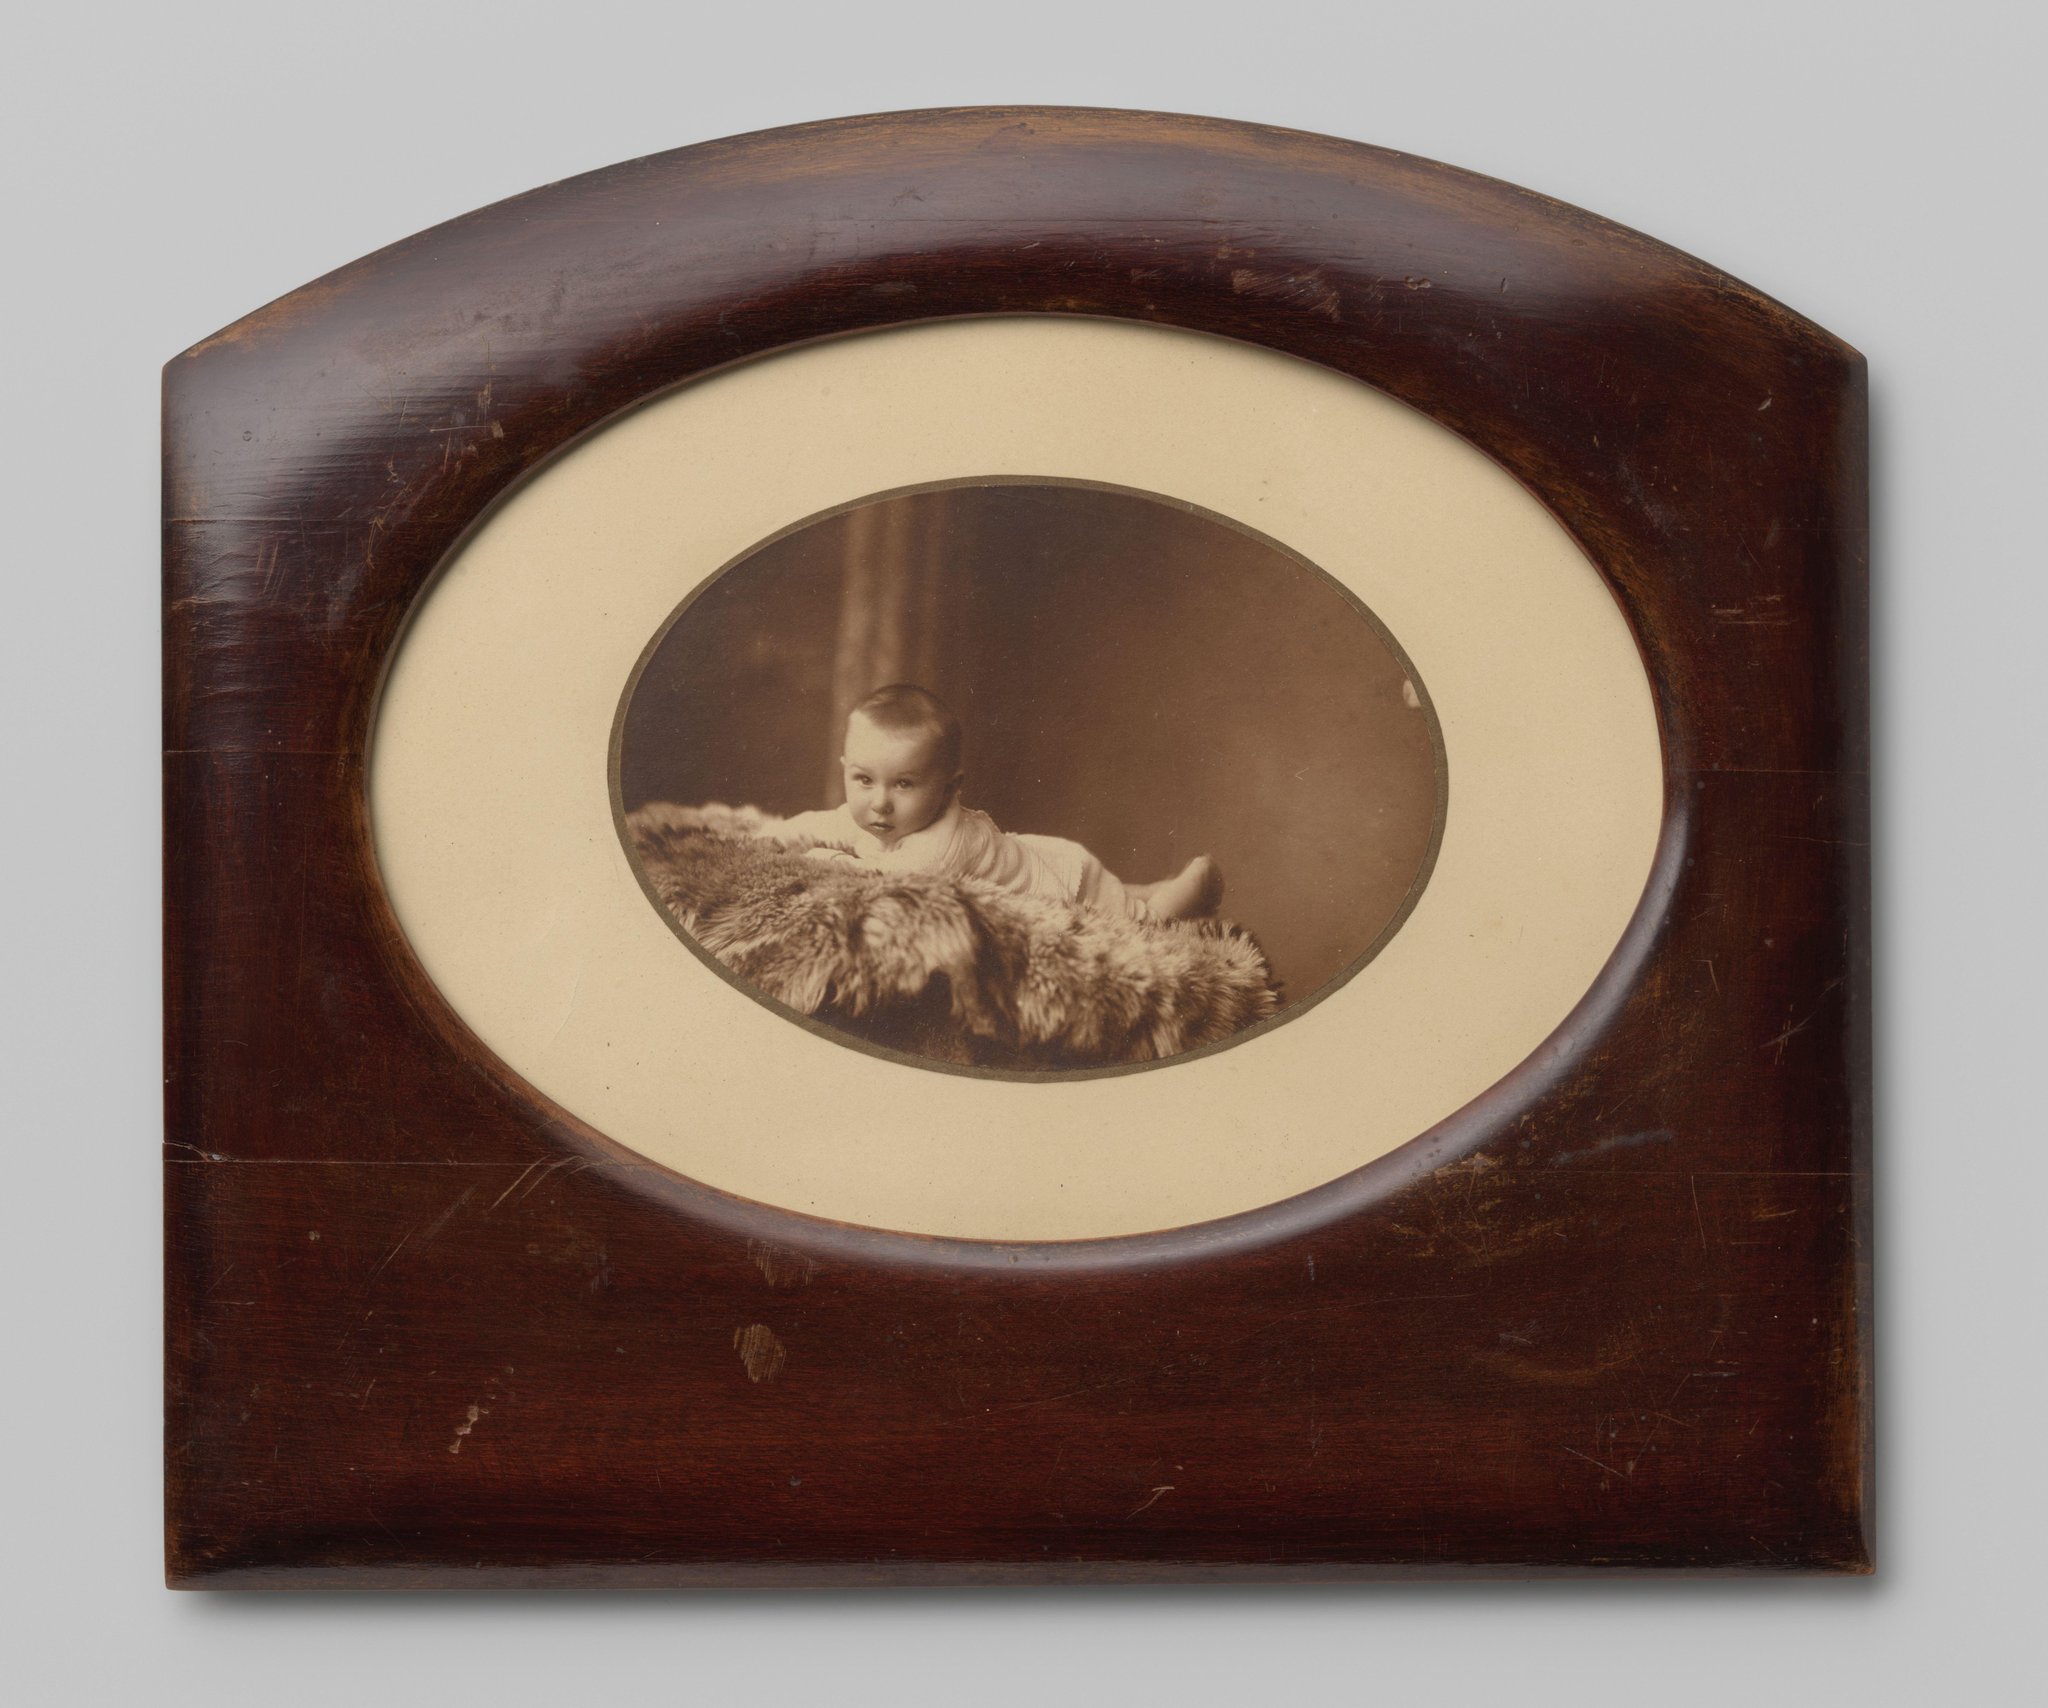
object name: frame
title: Portret van een onbekende baby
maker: Anonymous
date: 1900-1930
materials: paper, cardboard, glass, metal, fiber, wood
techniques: gelatin silver print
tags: historical persons, infant, baby ~ the ages of man